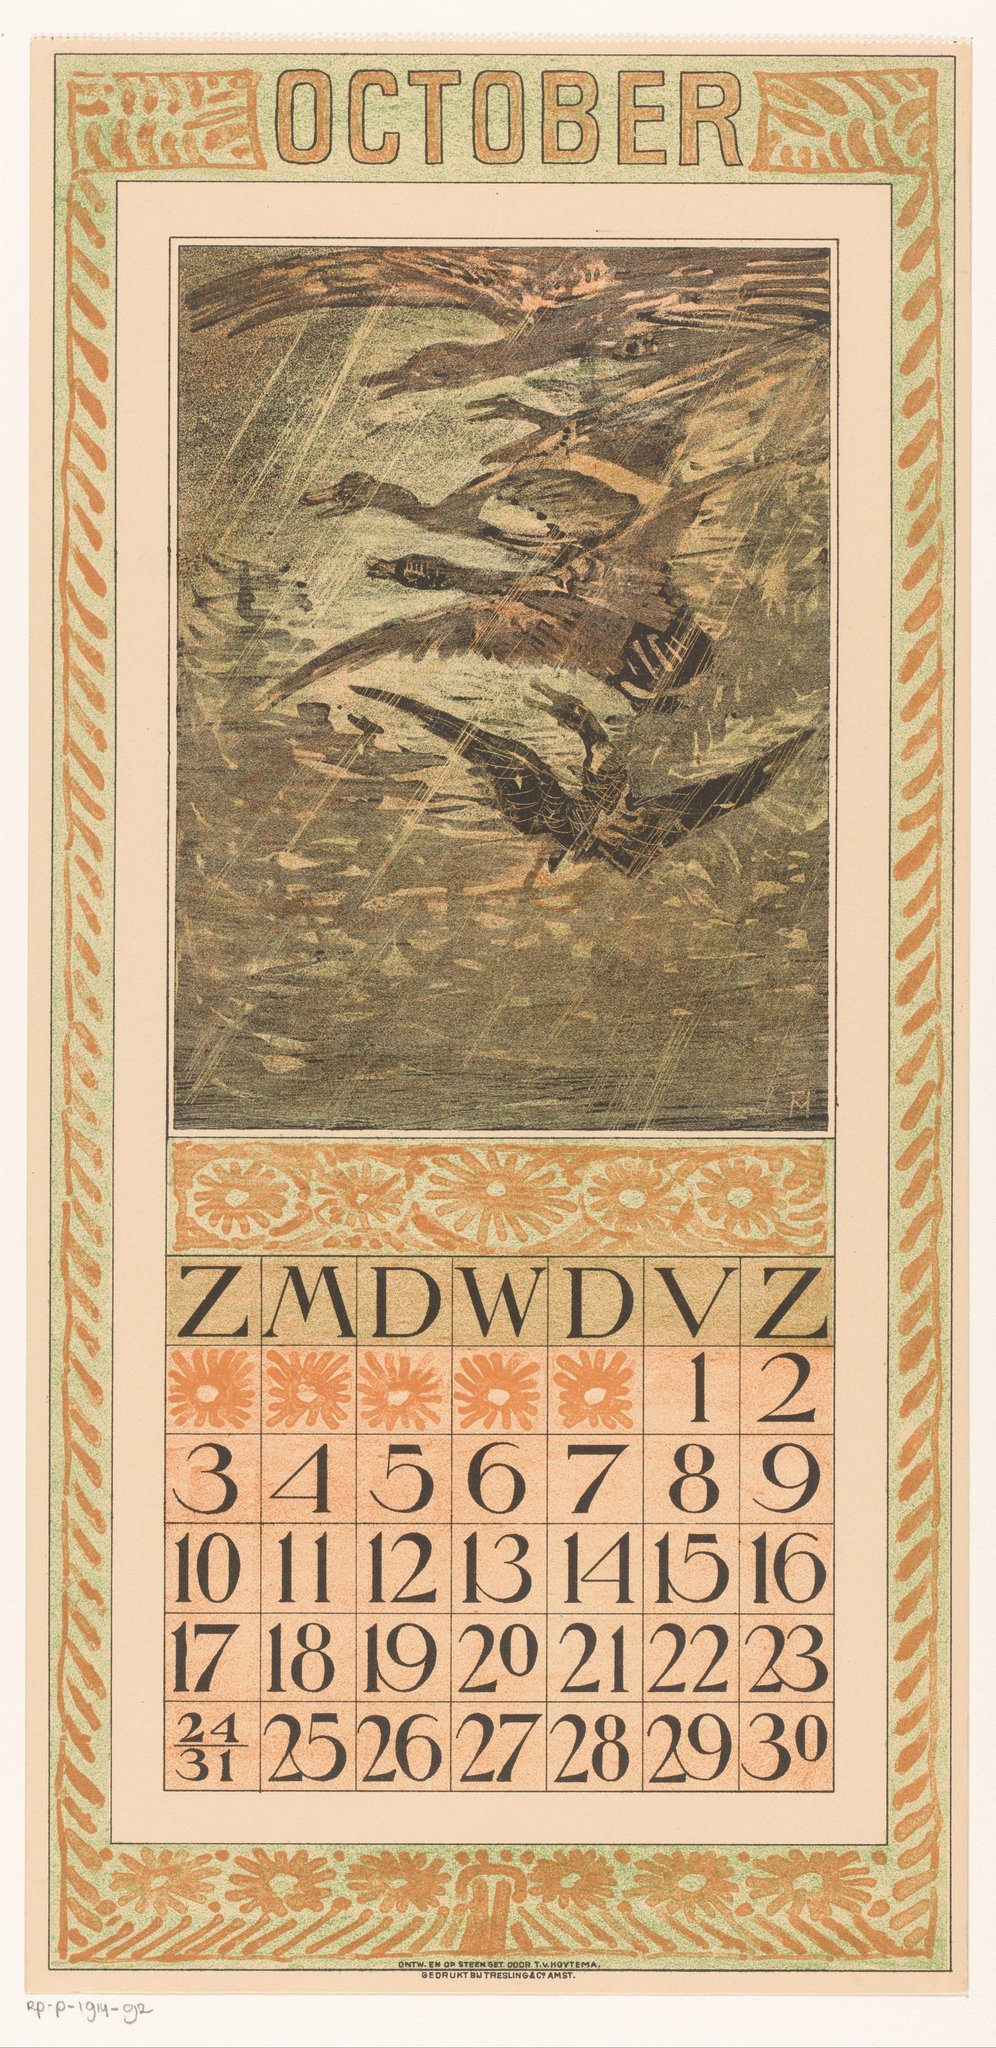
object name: calendar leaf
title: Kalender 1909 12 lithografien door Th. v. Hoytema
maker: theo van hoytema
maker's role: draughtsman, painter, print maker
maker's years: 1863-1917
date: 1908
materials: paper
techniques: lithograph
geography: the hague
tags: rain, water-birds: duck, october ~ other concepts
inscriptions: collector's mark: Lugt 2228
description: De eenden vliegen door de regen. Bovenaan het blad een scheurlijn.